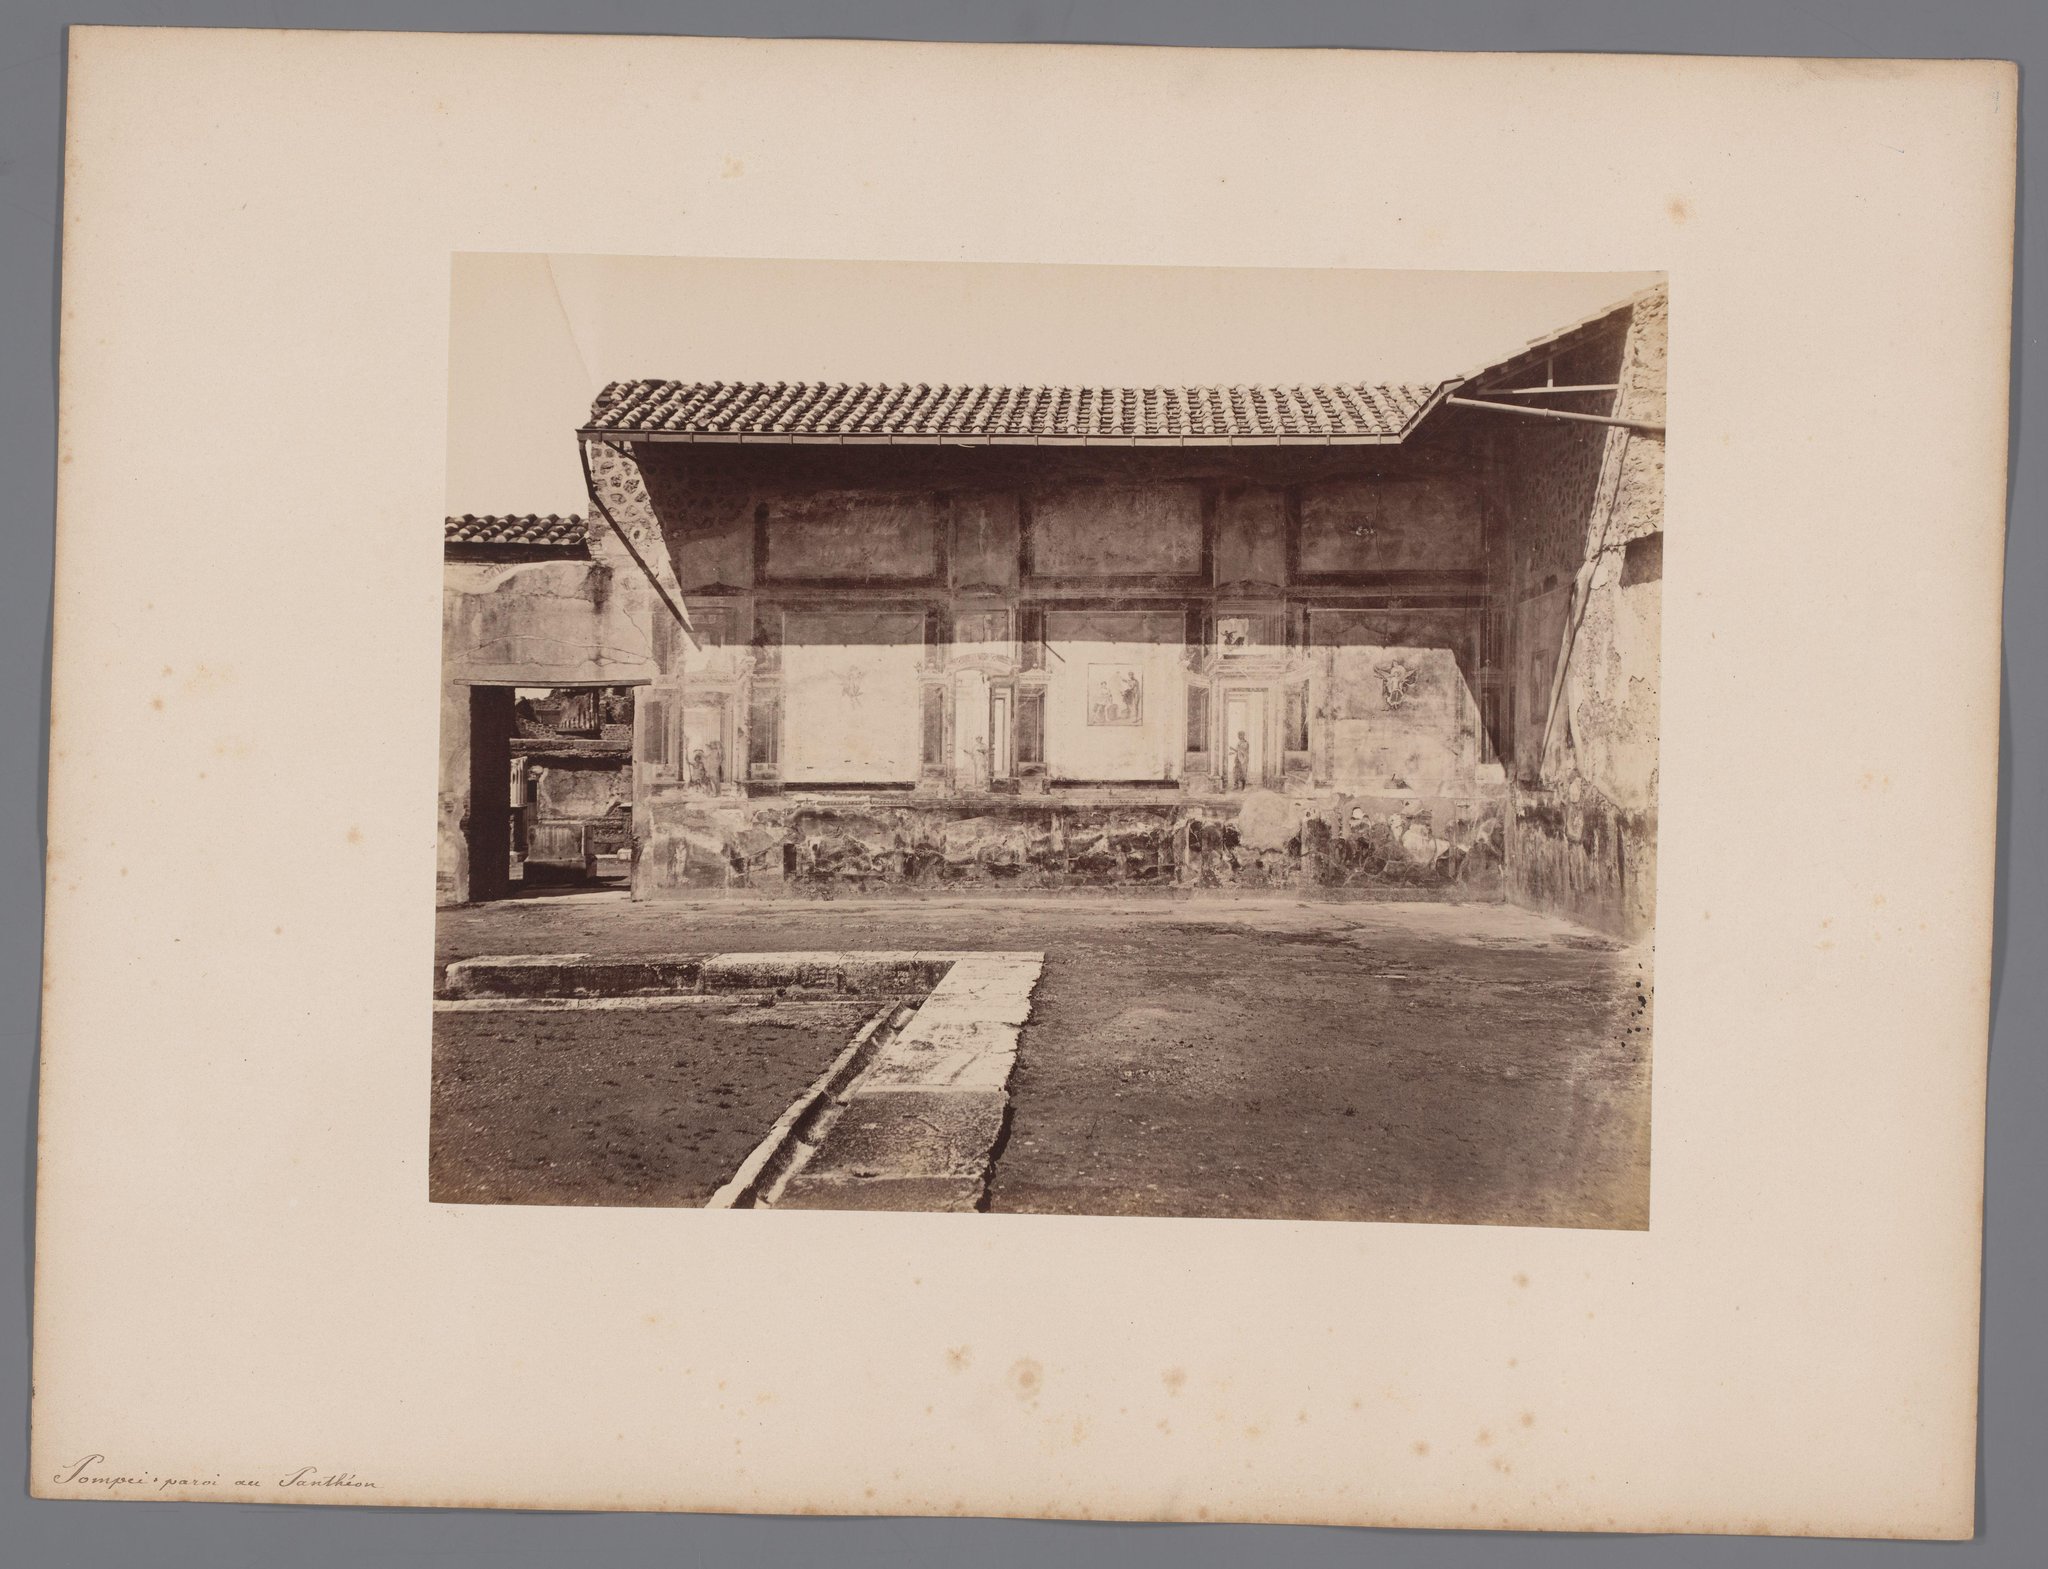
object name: photograph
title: Restanten van de Tempel van Augustus te Pompeï, Italië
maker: giorgio sommer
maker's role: fotograaf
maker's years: 1834-1914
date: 1857-1914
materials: cardboard, paper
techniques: albumen print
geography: pompeii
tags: ruin of a building ~ architecture, temple, shrine ~ roman religion, pompeii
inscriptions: number: ‘10’, number: ‘31.’, inscription: ‘Sommer (t)’